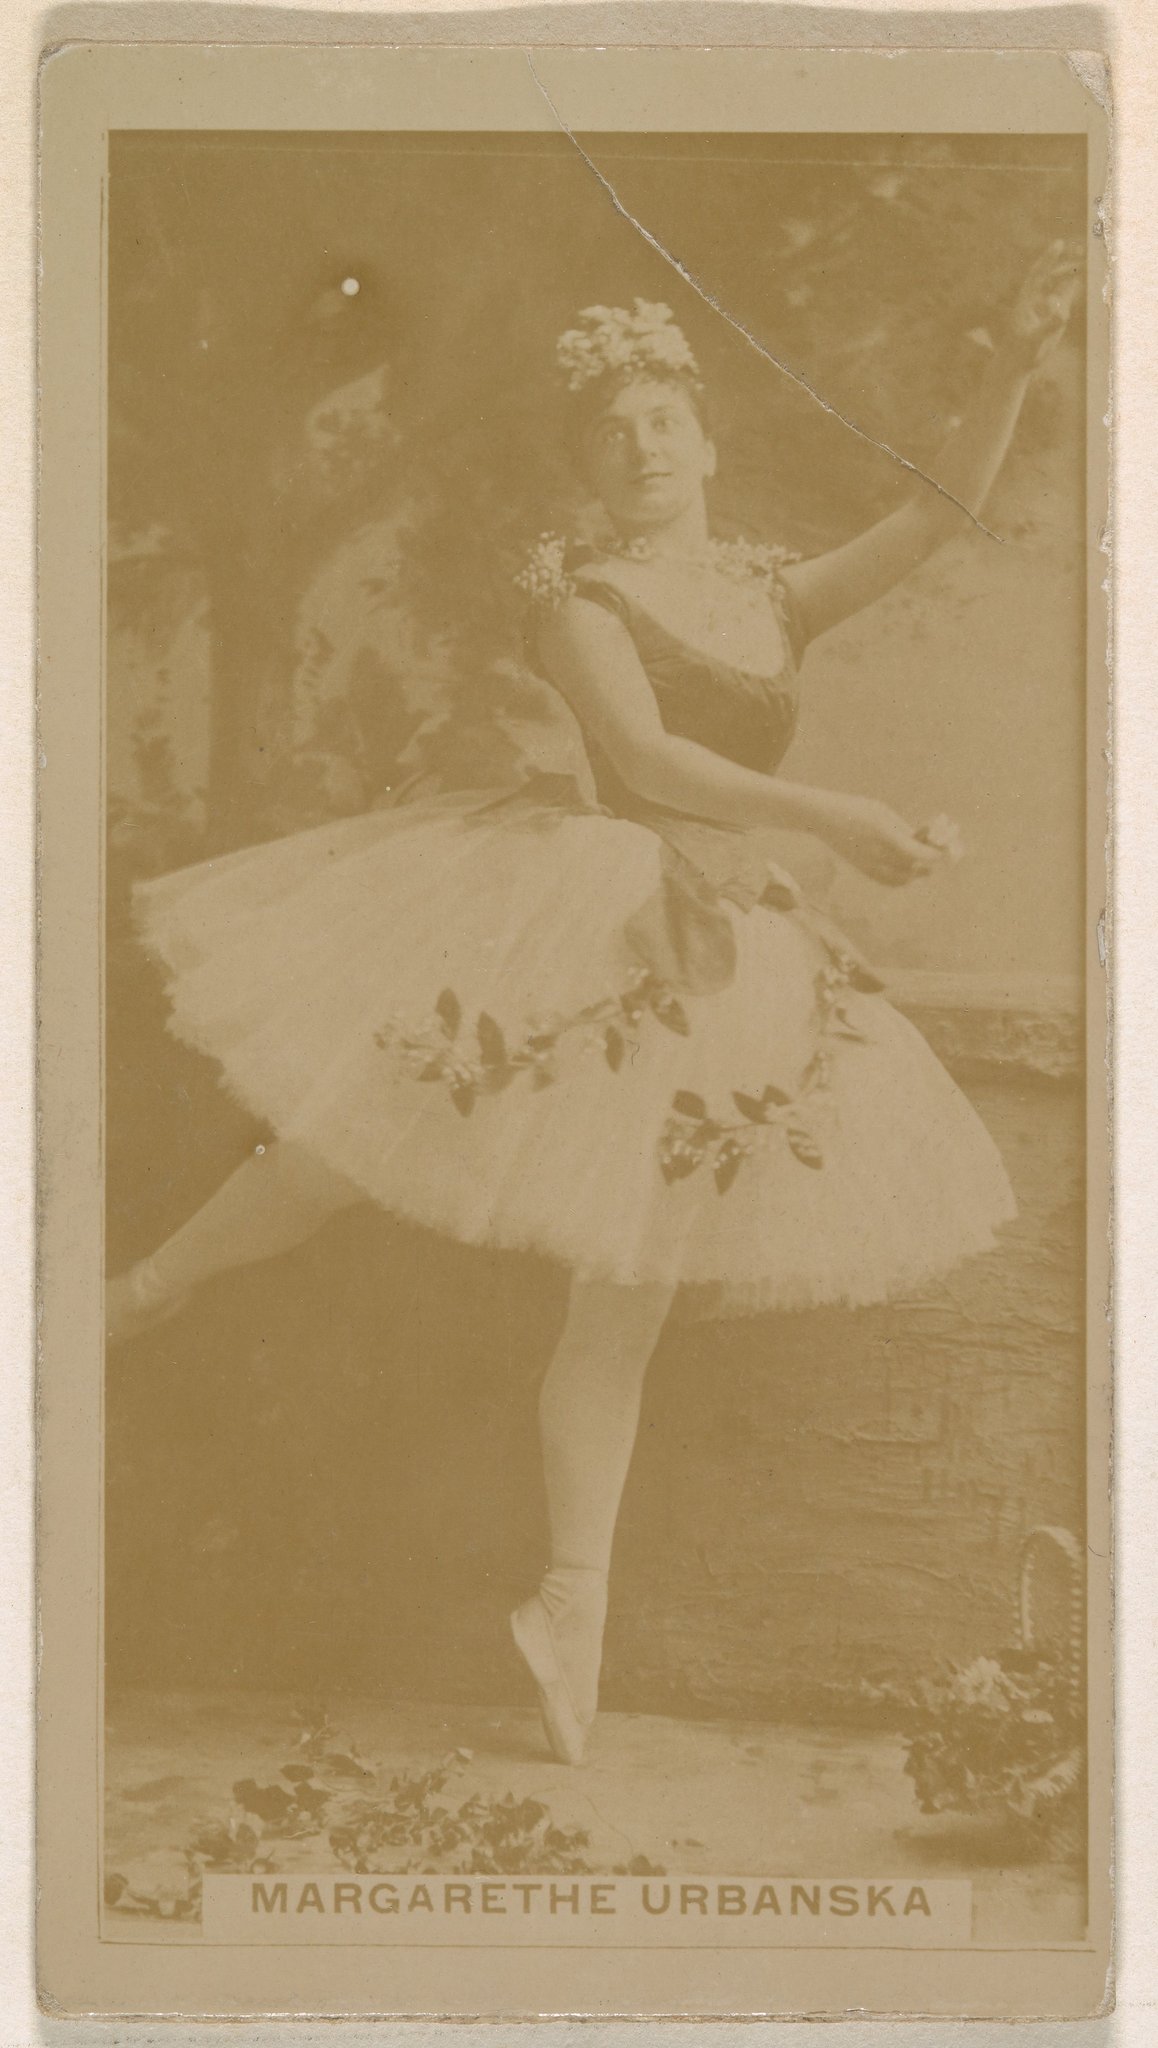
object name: photograph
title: Margarethe Urbanska, from the Actresses series (N245) issued by Kinney Brothers to promote Sweet Caporal Cigarettes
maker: kinney brothers tobacco company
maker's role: publisher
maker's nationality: american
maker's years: 1869-2011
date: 1890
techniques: albumen silver print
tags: portraits,women,actresses